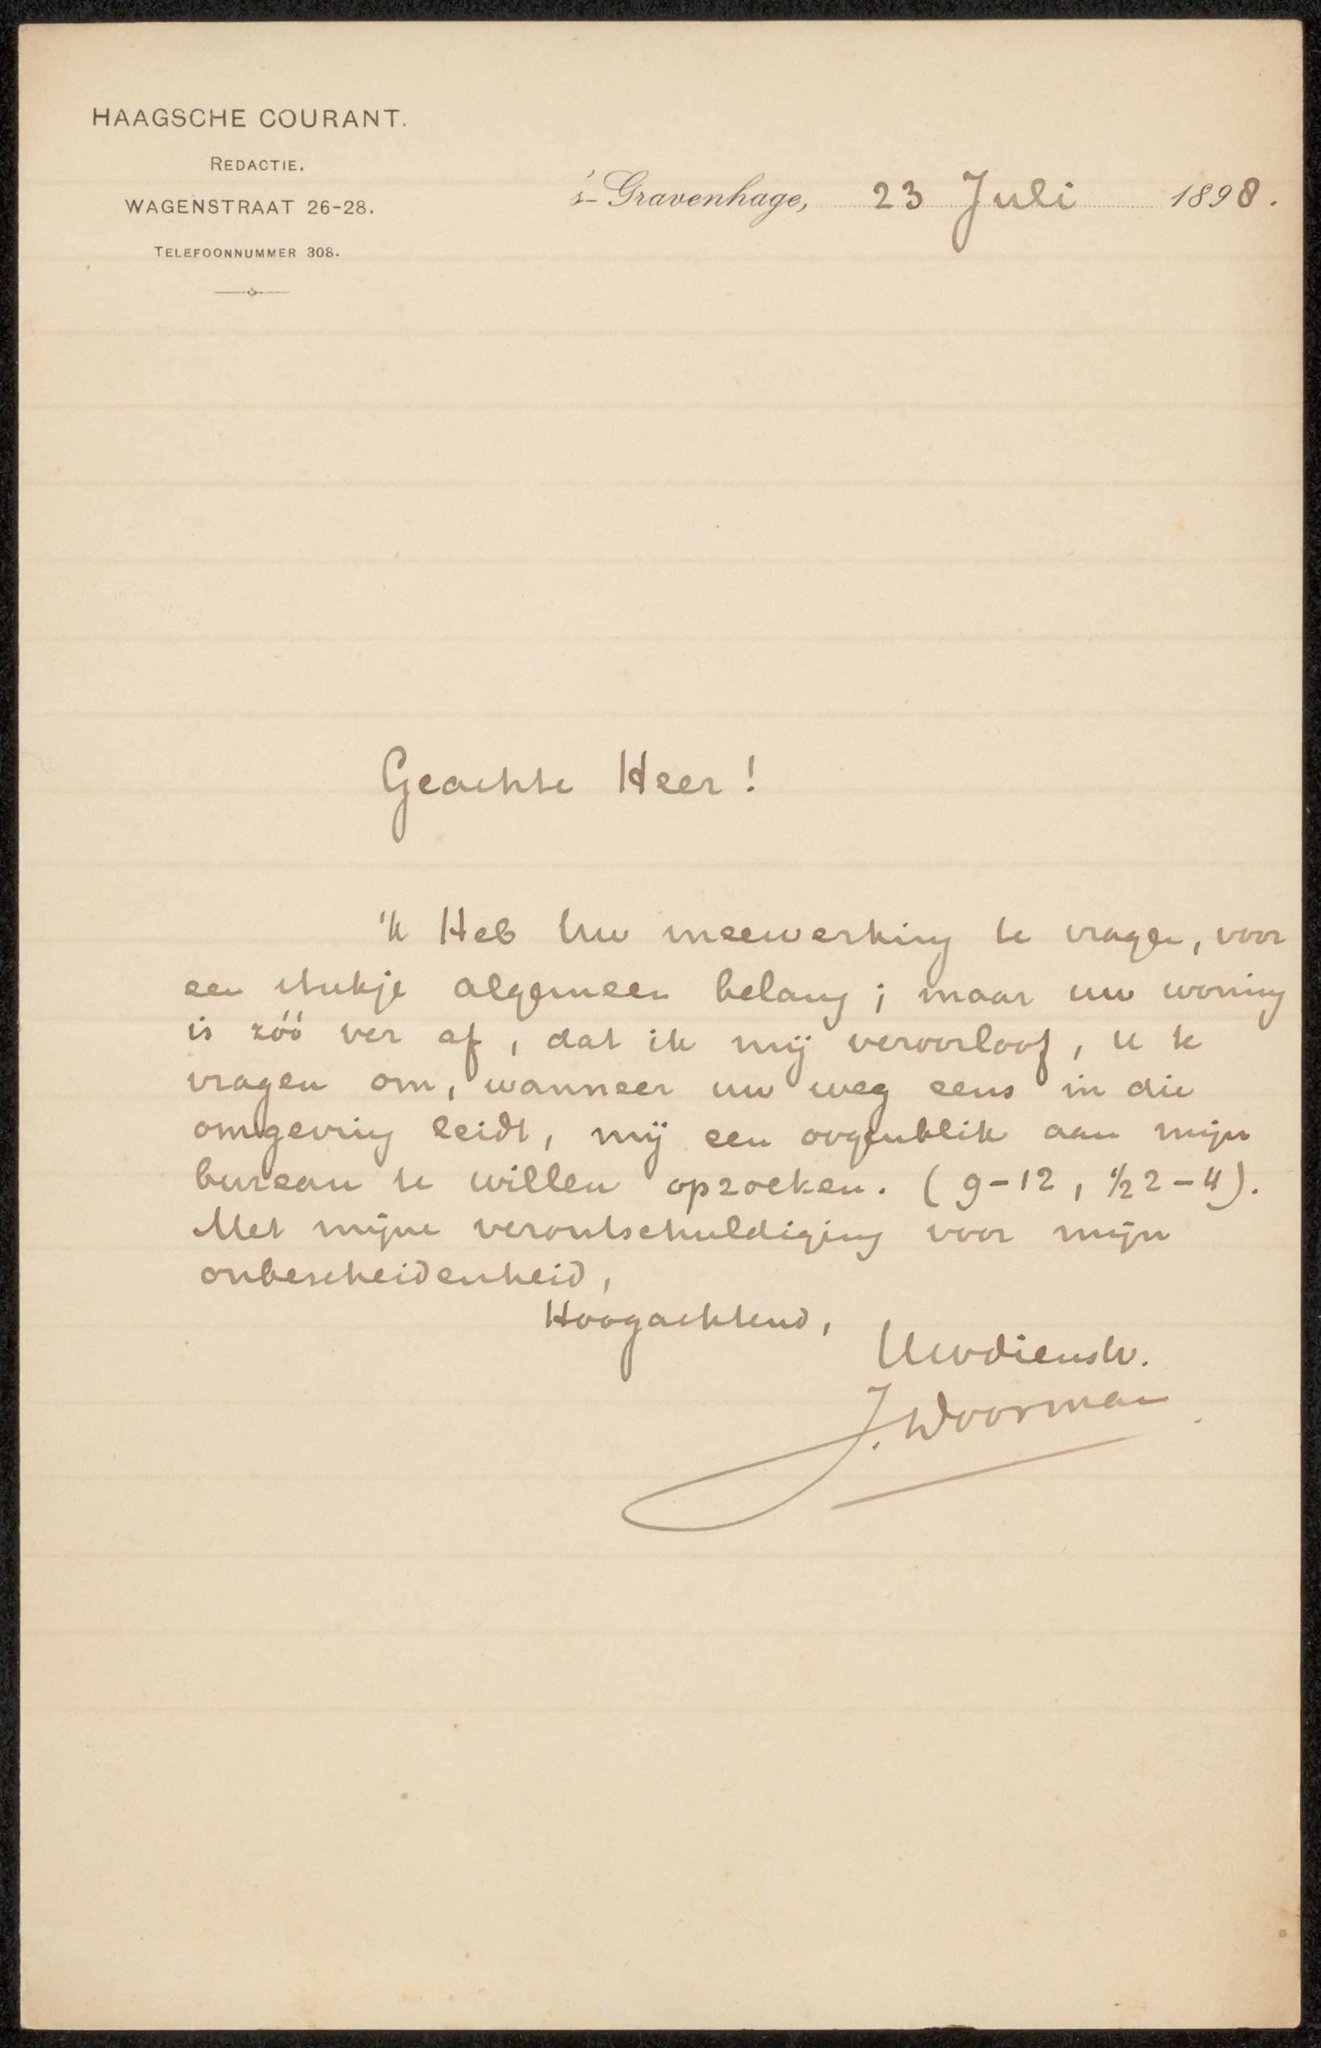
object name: letter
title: Brief aan Philip Zilcken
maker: j. doorman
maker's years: -1913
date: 1898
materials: ink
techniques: pen, printing, writing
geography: the hague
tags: painter, draughtsman, philip zilcken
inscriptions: collector's mark: ‘RPK’